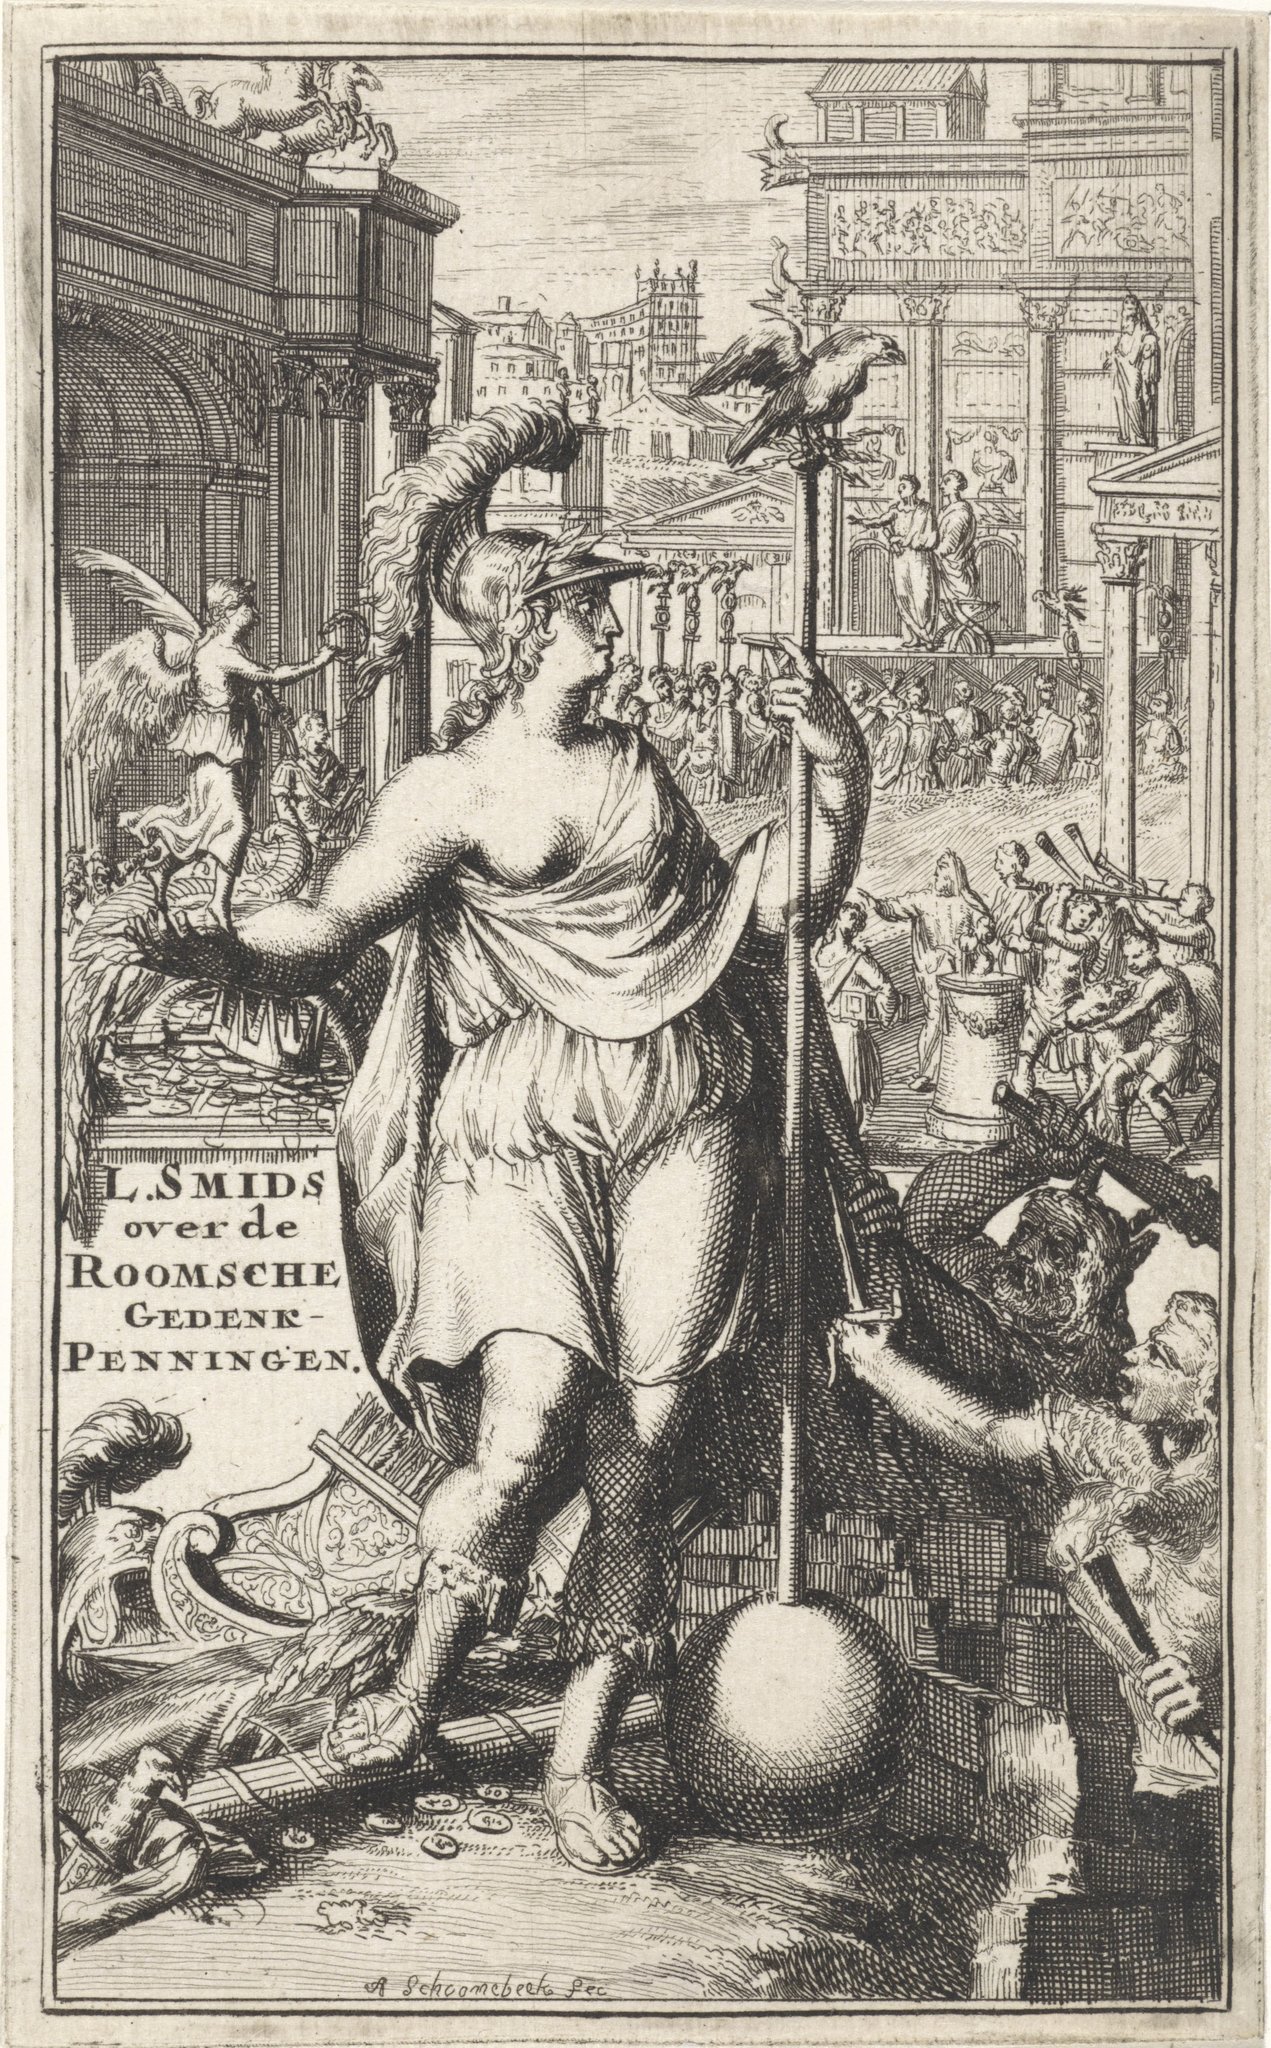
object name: print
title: Personificatie van de stad Rome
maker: adriaen schoonebeek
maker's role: print maker, publisher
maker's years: 1661-1705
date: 1693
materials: paper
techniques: etching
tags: personification of a city, town-patron(ess), rome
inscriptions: collector's mark: Lugt 2228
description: Met Romeinse gebouwen op de achtergrond, staat de personificatie van de stad Rome naast een sokkel. Op haar hand een klein beeld van Victoria. Met haar andere hand houdt zij een staf vast waarop een feniks zit.